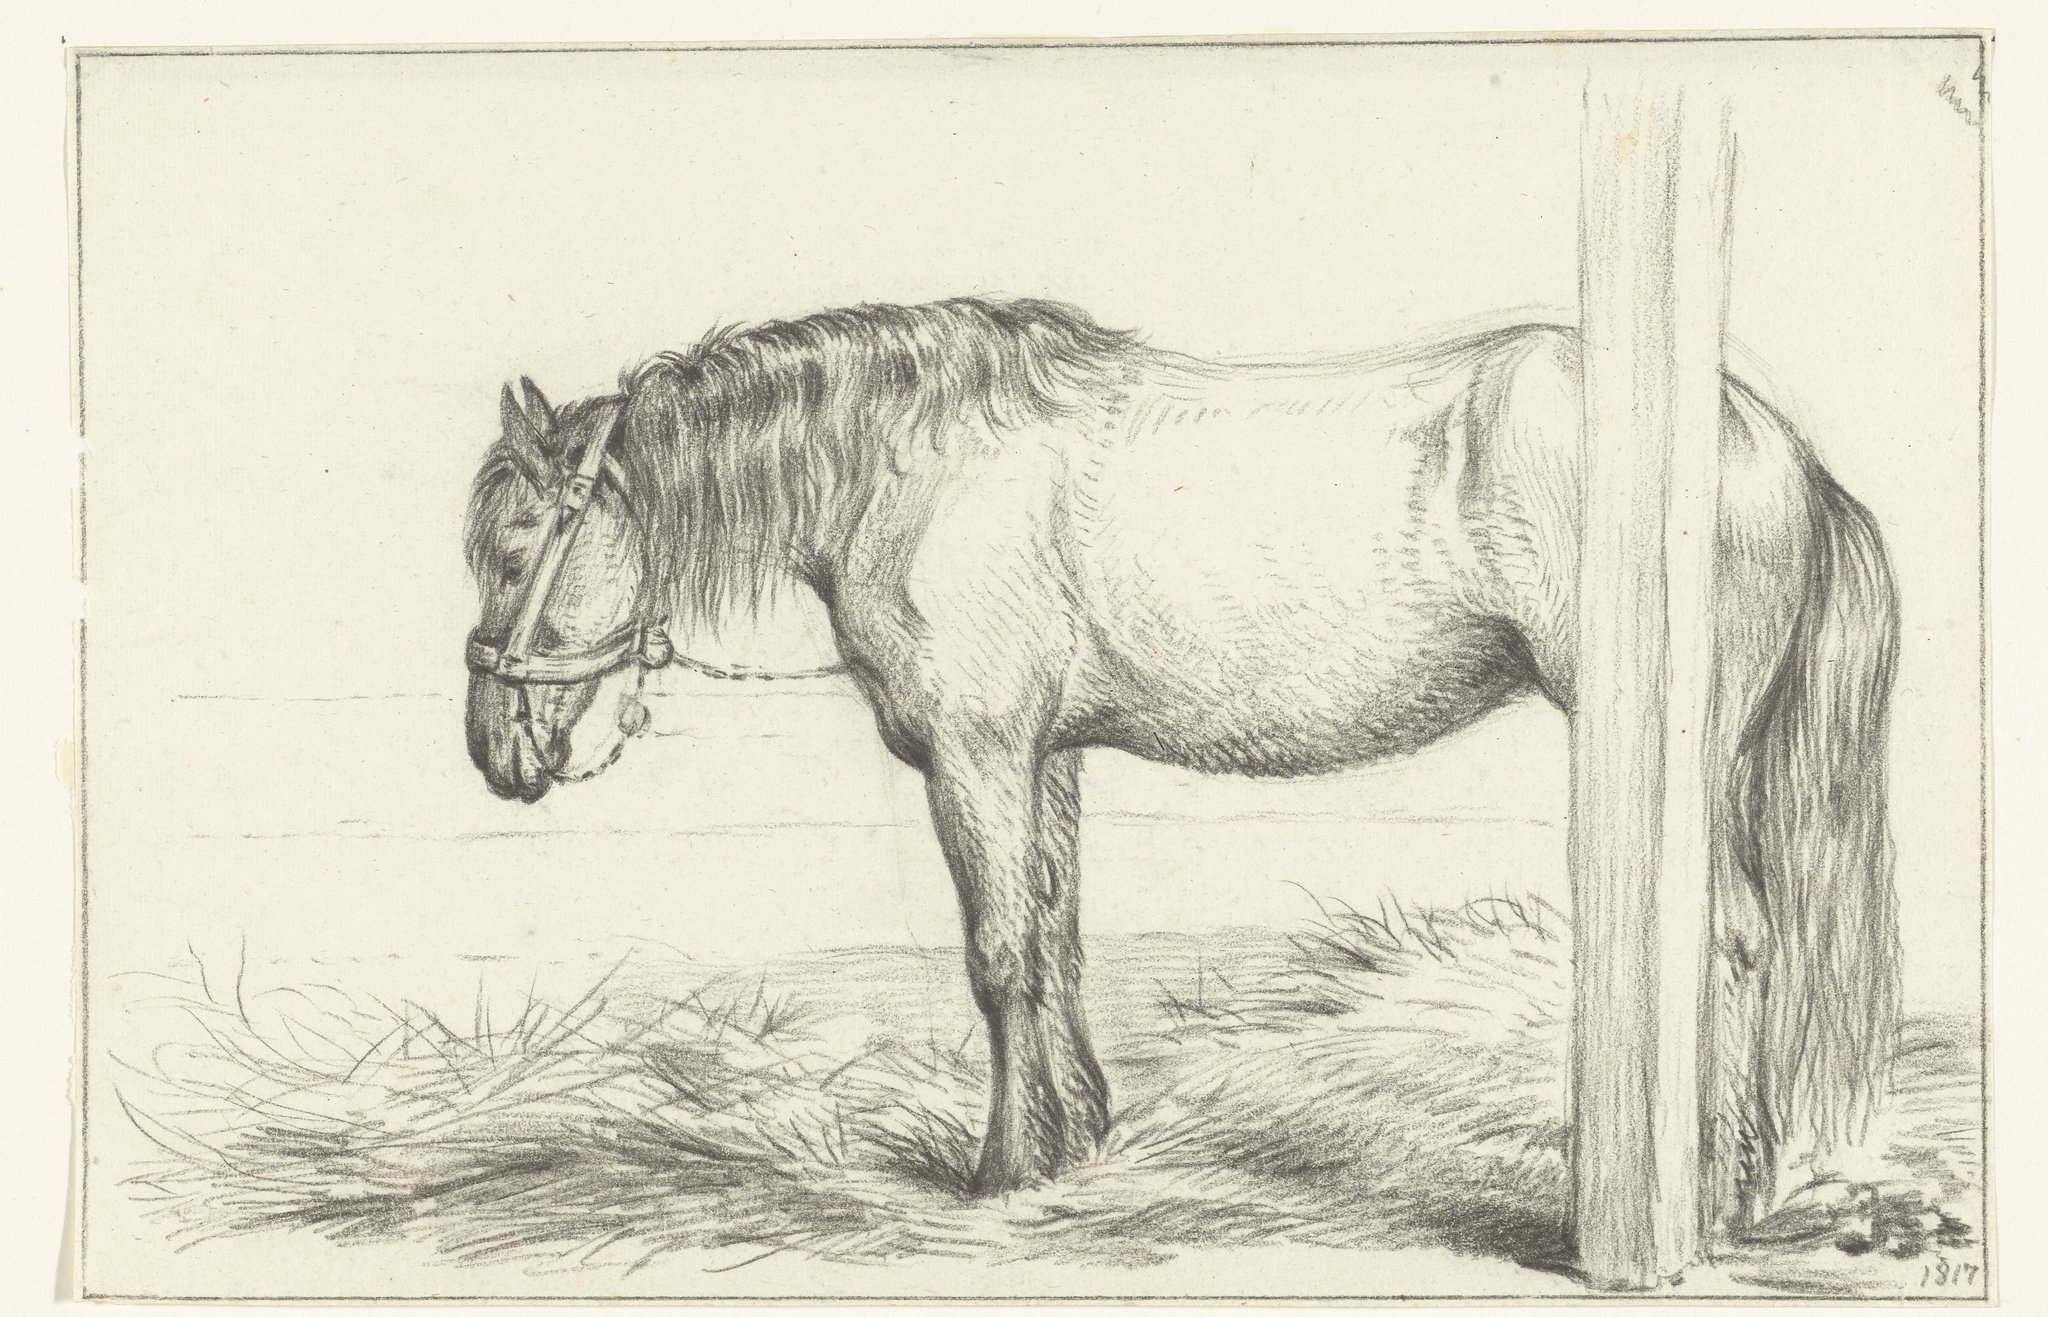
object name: drawing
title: Staand paard in stal, naar links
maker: jean bernard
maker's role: draughtsman, print maker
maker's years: 1765-1833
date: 1817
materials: chalk, paper, pencil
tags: horse